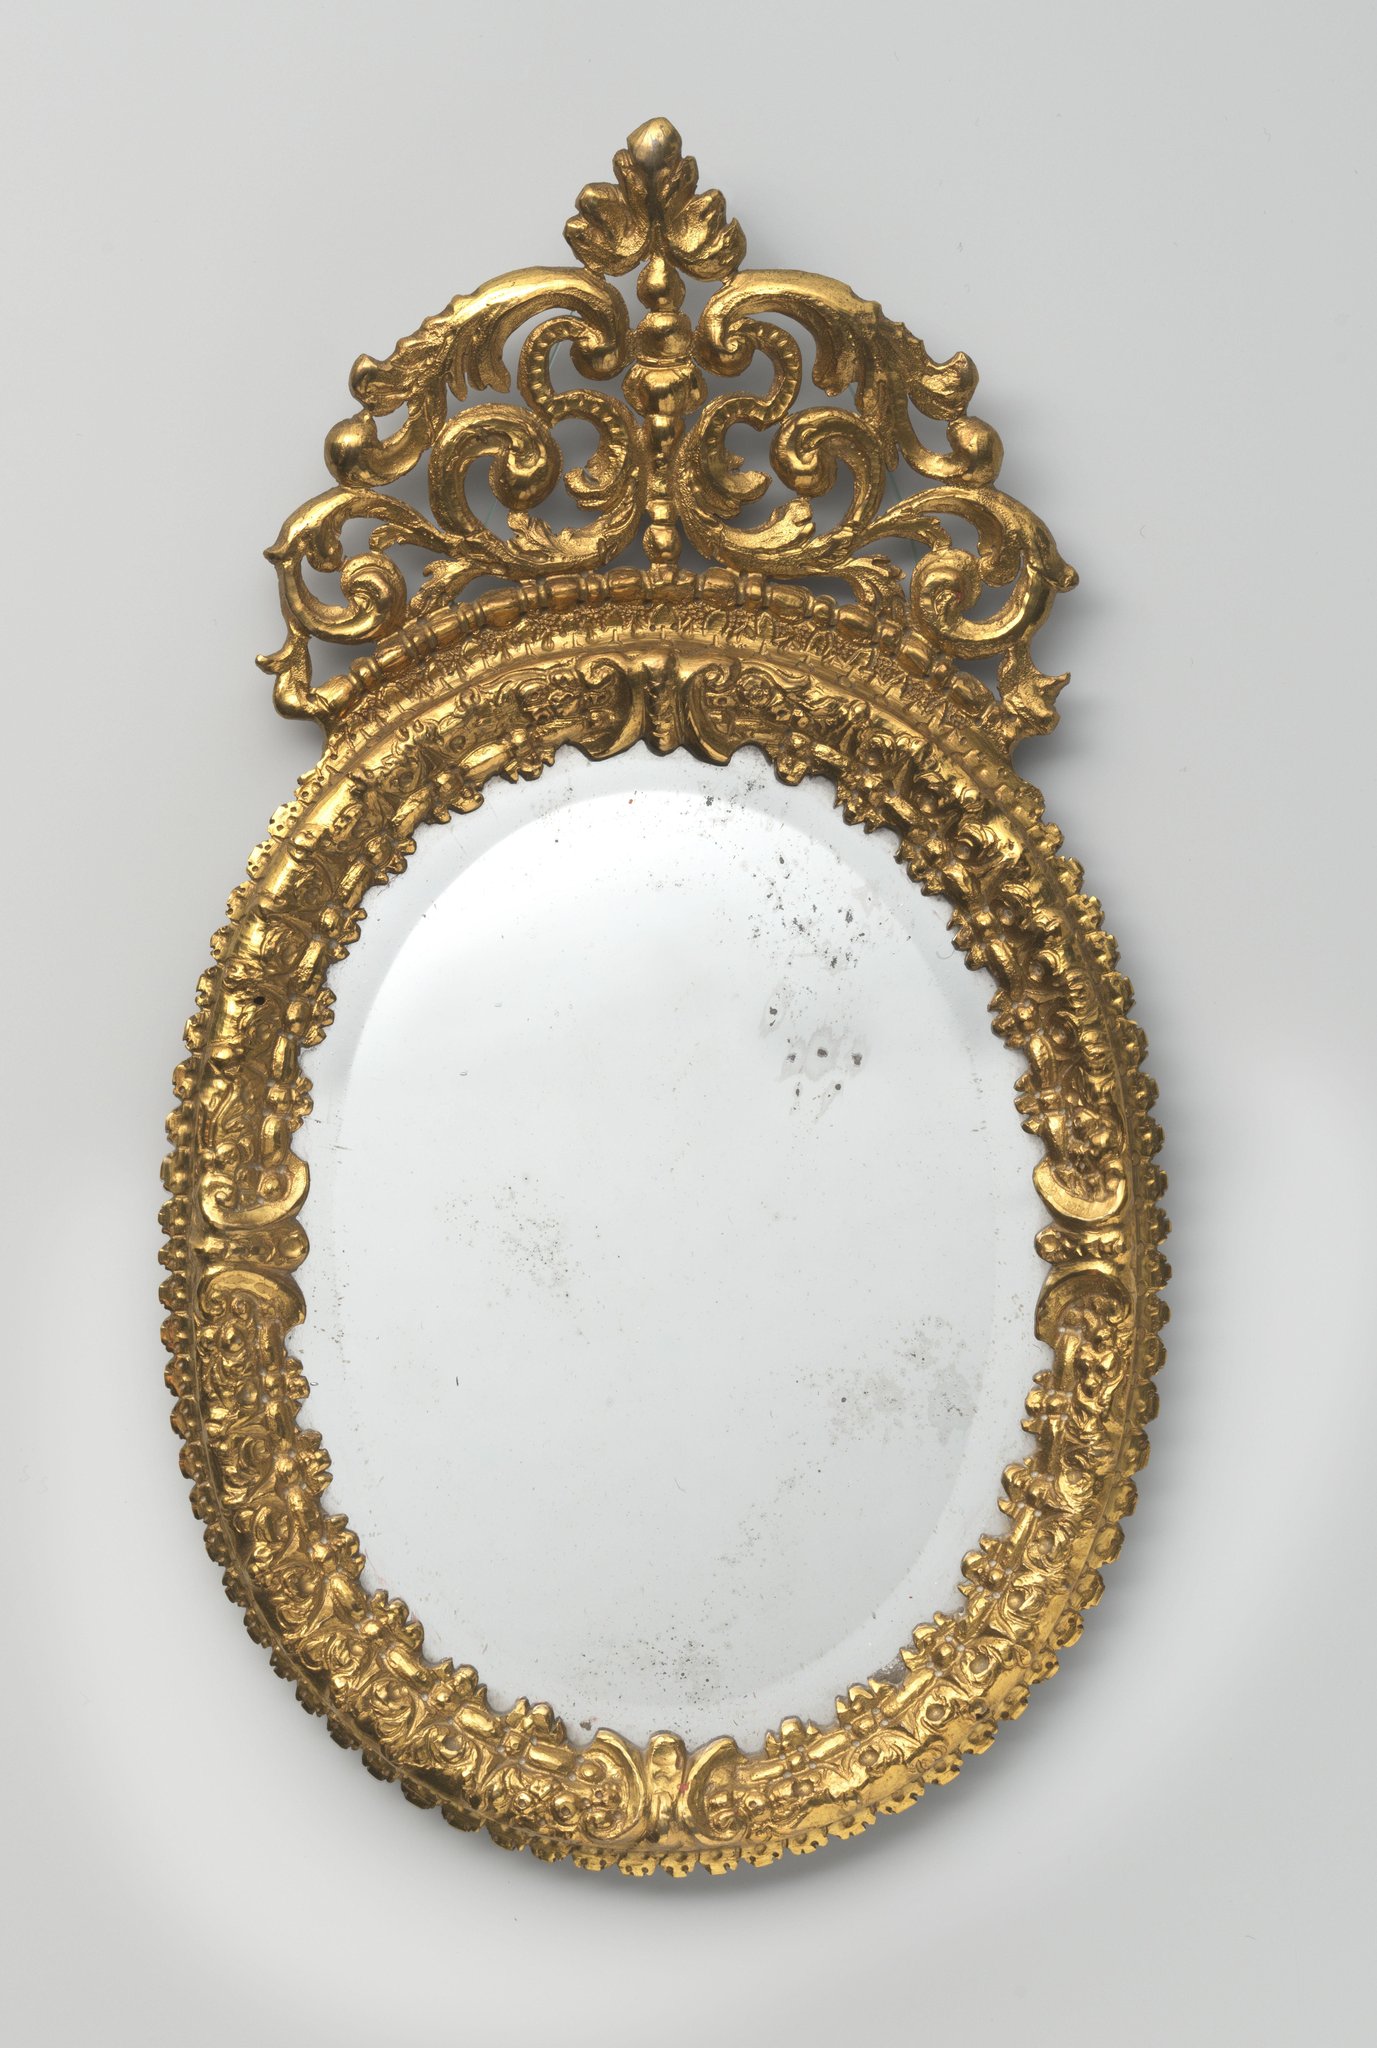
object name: miniature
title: Ovale spiegel in een verguld bronzen lijst. In de lijst een oud, nauwelijks gecorrodeerd spiegelglas met geslepen facetrand, aan de achterzijde afgesloten door houten paneel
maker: Anonymous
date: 1690-1710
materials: amalgam, bronze, glass, wood, wool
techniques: gilding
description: Ovale spiegel in een verguld geornamenteerd verguld bronzen lijst, versierd met schulpen, gestileerde acanthusblad motieven op gespikkelde achtergrond, onderbroken parelrand, en dubbele voluten op de vier middens van de bogen. De lijst wordt bekroond door een ornament van symmetrisch gegroepeerde bladranken. In de lijst een oud, maar nauwelijks gecorrideerd spiegelglas met geslepen facetrand, aan de achterzijde afgesloten door een houten paneel en twee latjes. Tussen glas en hout een wollen weefsel (zoals ook aangetroffen bij de 18de eeuwse spiegeltjes in het Grachtenhuis: BK-NM-5783-19).